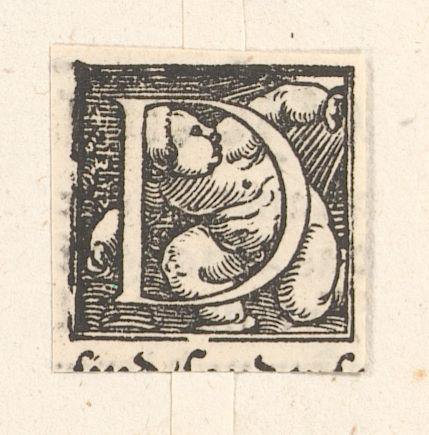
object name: album leaf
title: Romeins alfabet met kinderen in verschillende houdingen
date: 1524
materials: paper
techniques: metal cut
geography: switzerland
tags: throwing games, initial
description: Dit initiaal mogelijk gebruikt in: Das Alte Testament Deutsch ..., Basel: A. Petri, december 1523. Ook in latere publicaties van Petri werd het initiaal gebruikt.